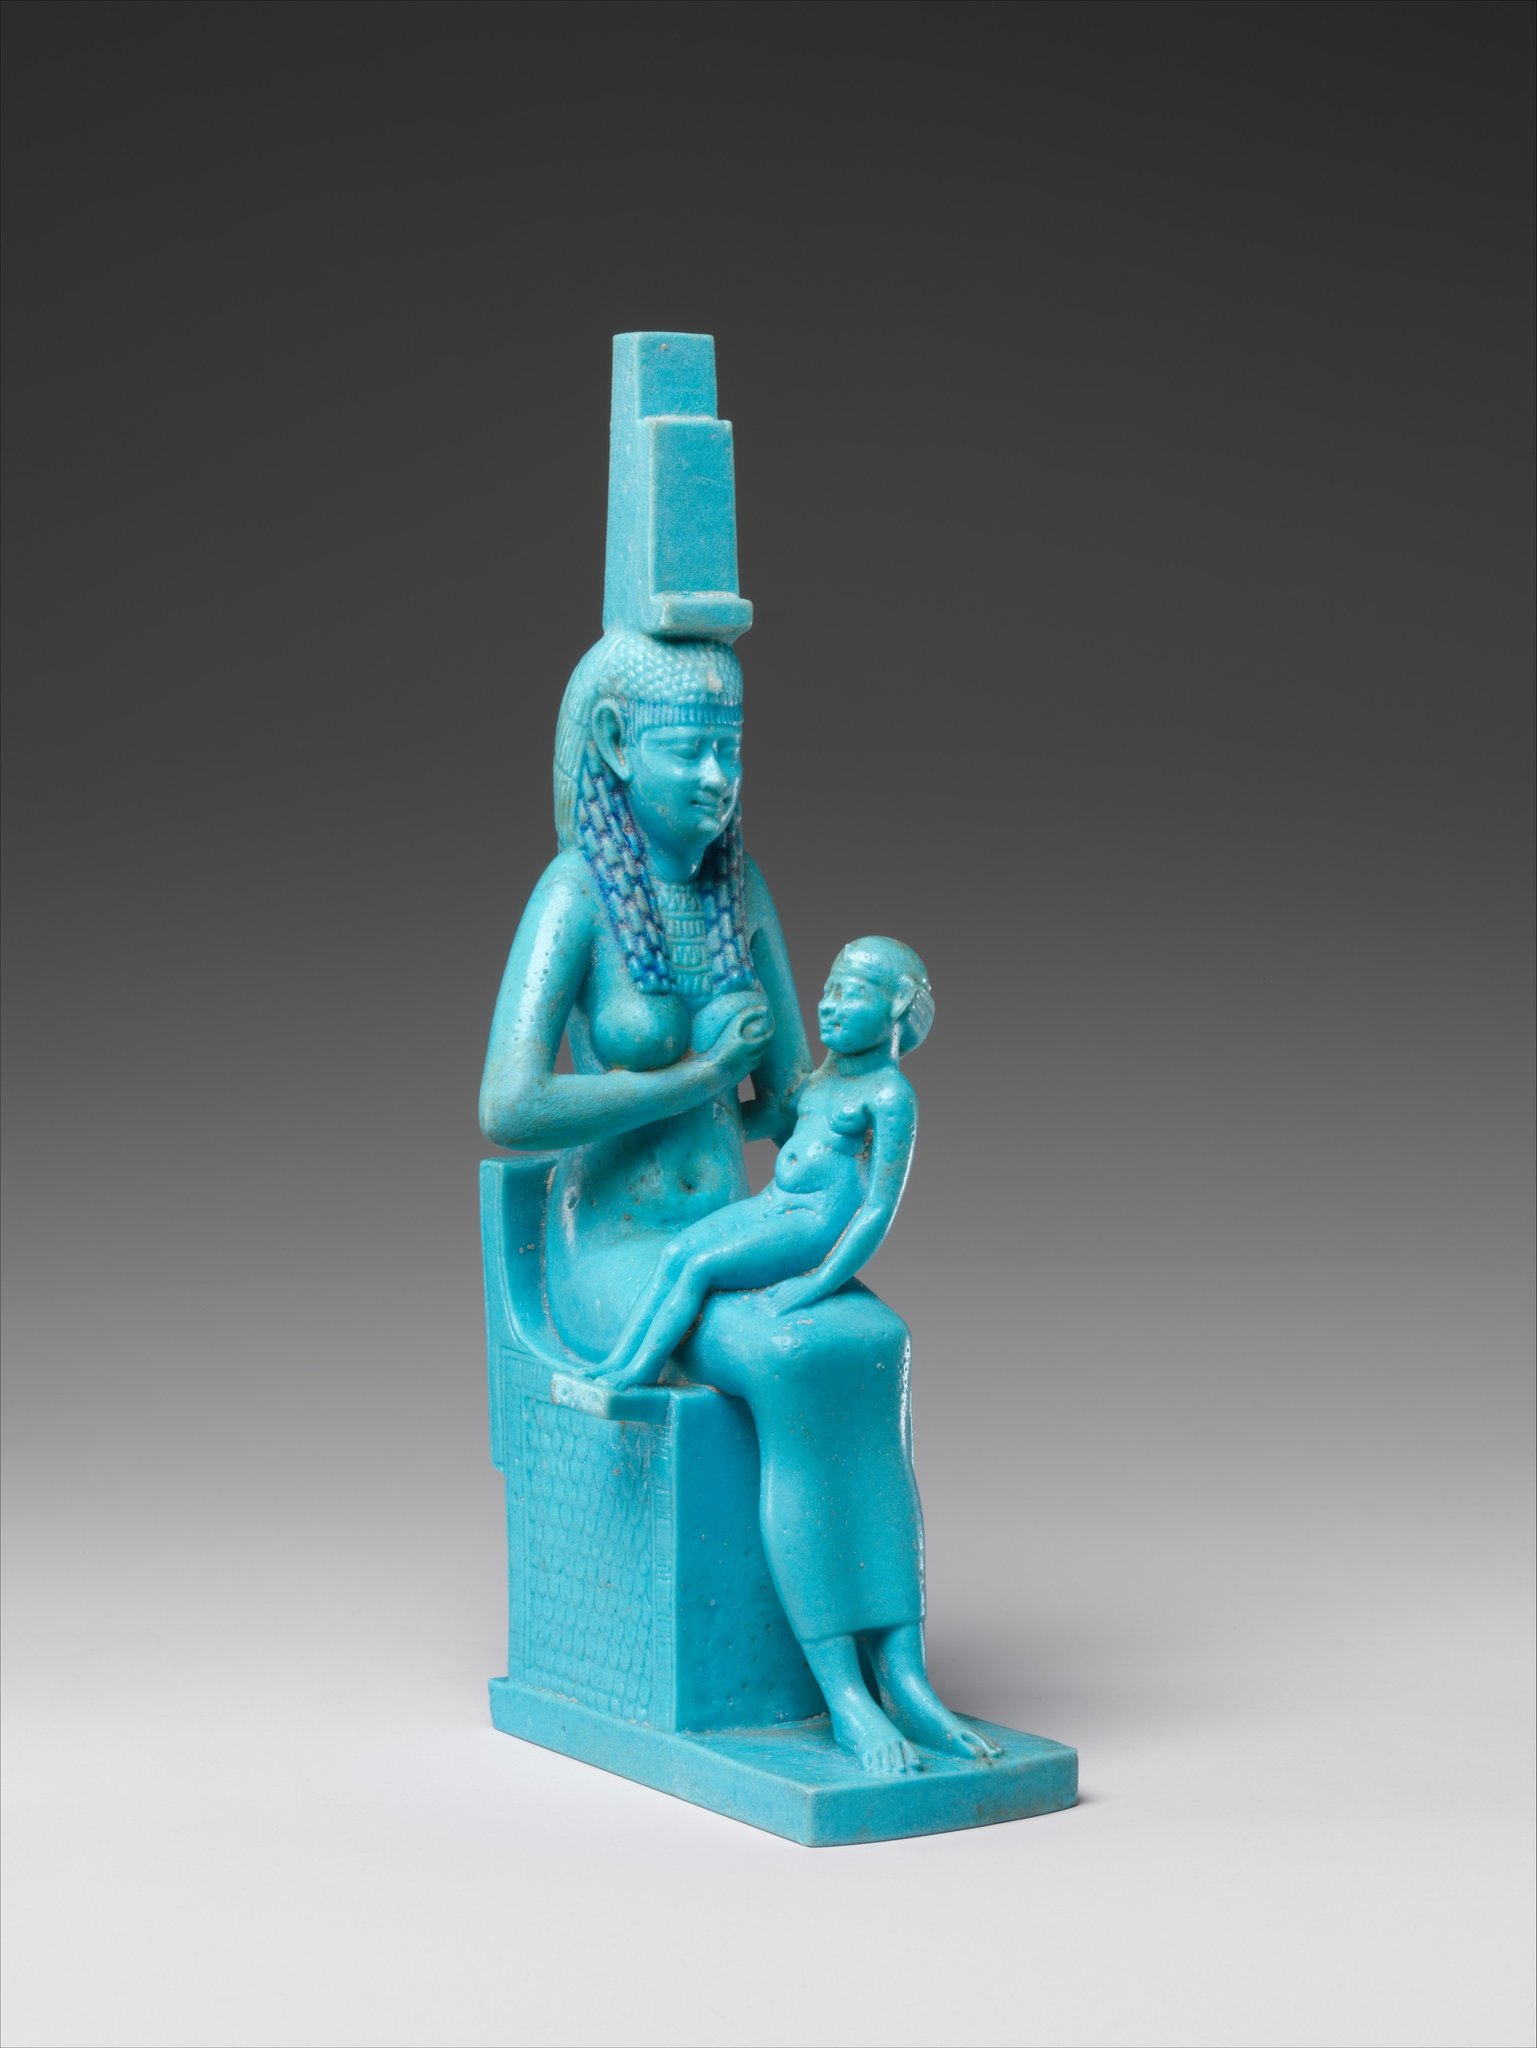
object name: statuette, isi, horus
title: Statuette of Isis with the infant Horus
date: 332-330 BCE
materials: faience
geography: egypt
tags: horus,isis,nursing